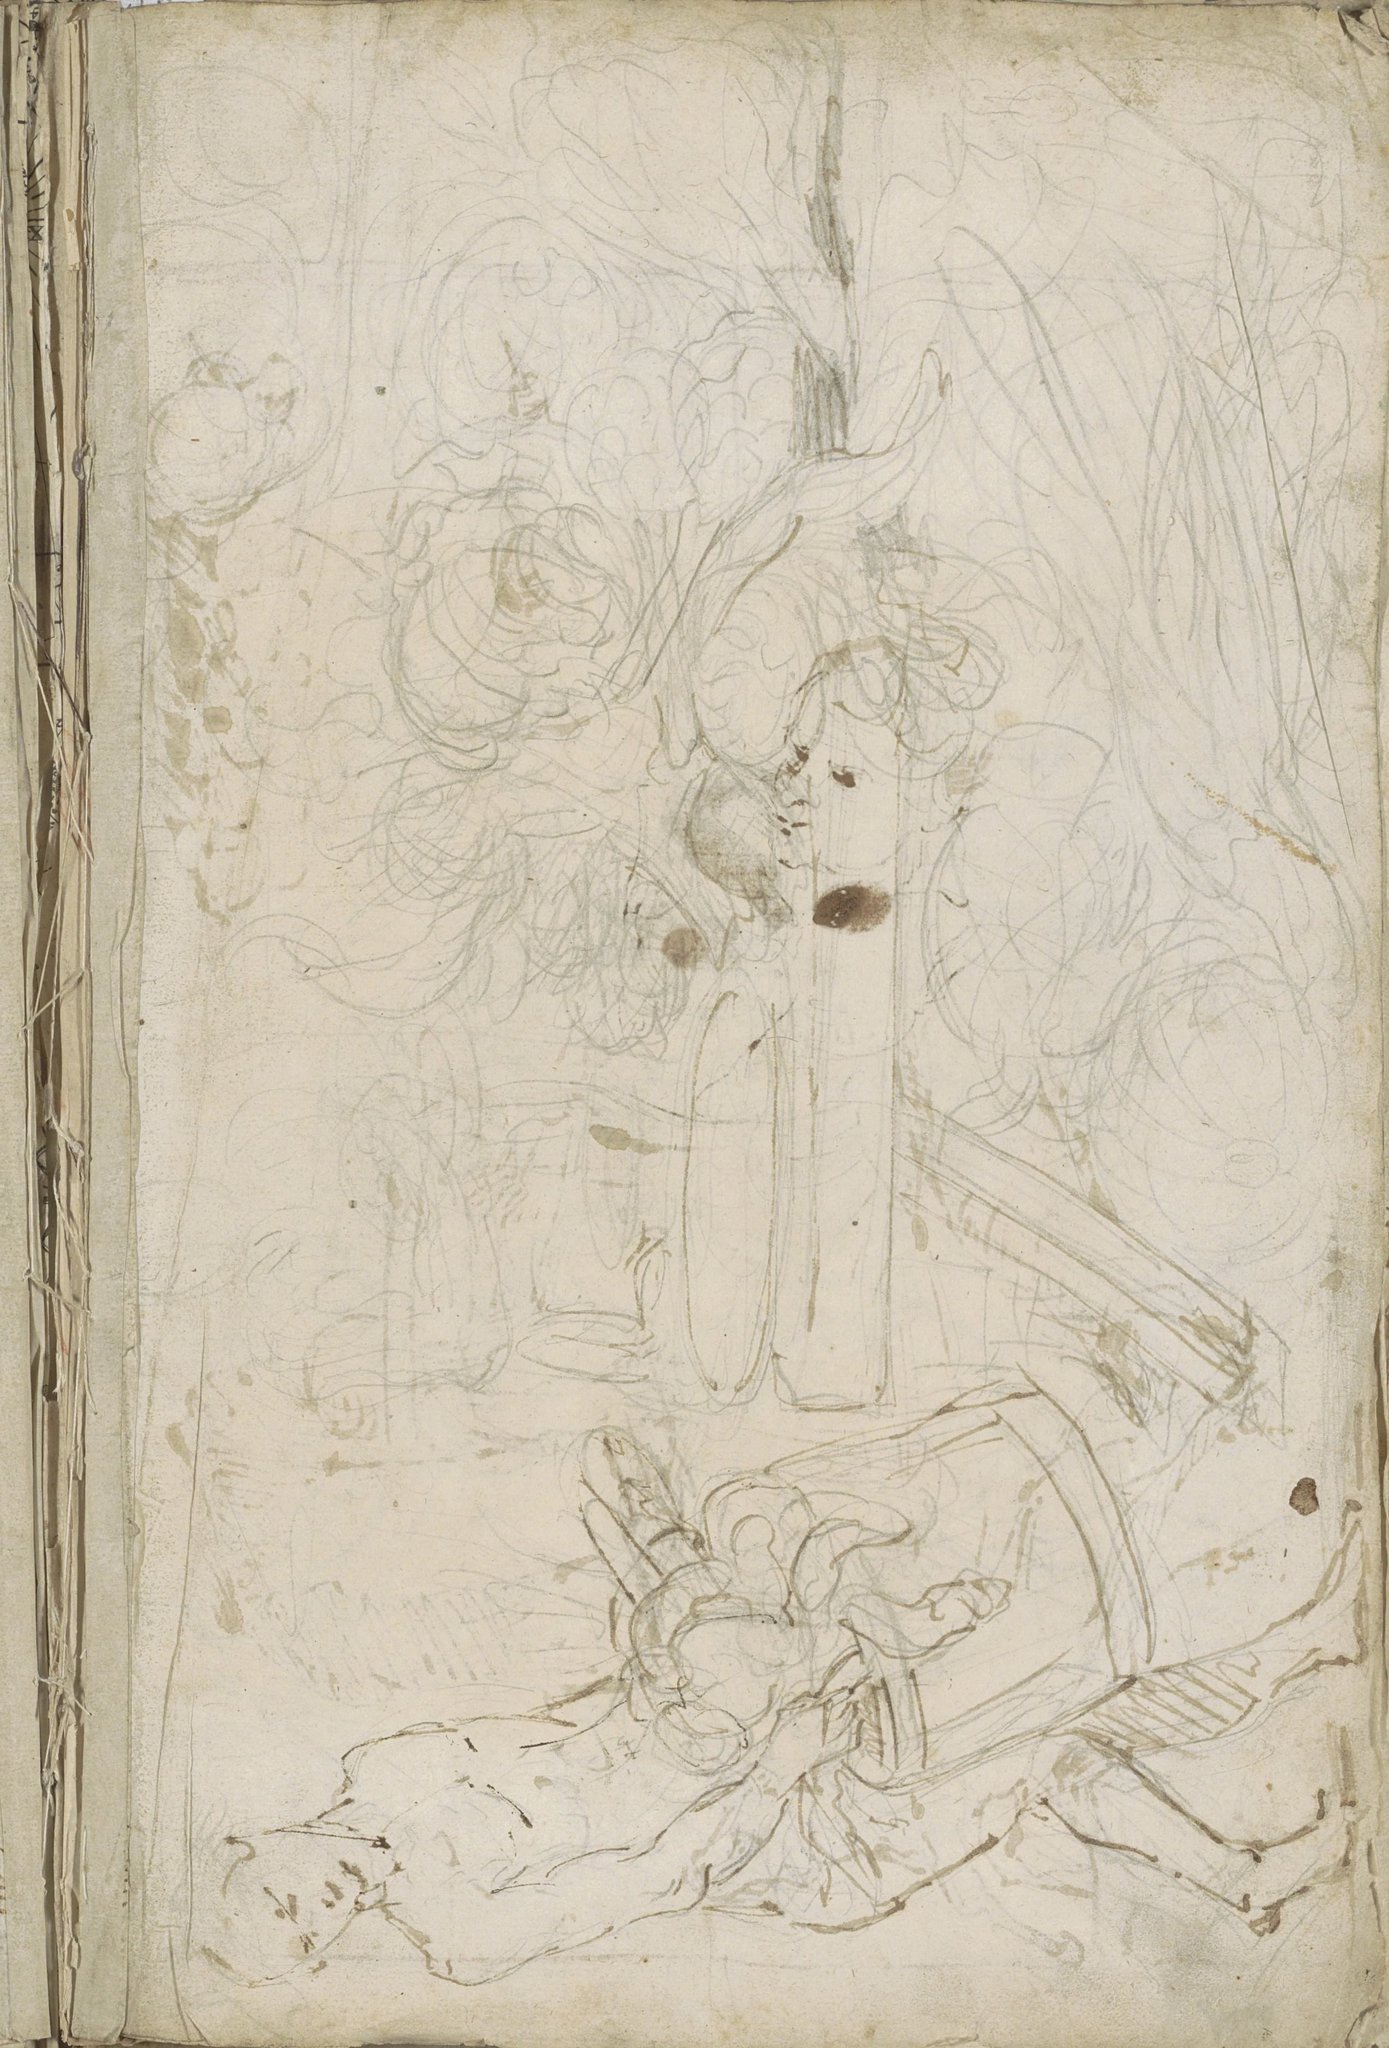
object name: sketchbook leaf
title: Man die een ton draagt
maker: paul de vos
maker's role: draughtsman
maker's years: 1595-1678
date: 1605-1678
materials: ink, paper, pencil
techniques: pen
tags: wooden container: barrel, cask, bucket, carrying something, table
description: In de ton zit vermoedelijk voedsel of een jachtbuit. Op de achtergrond een tafel. Blad 9 recto uit een schetsboek met 15 bladen.